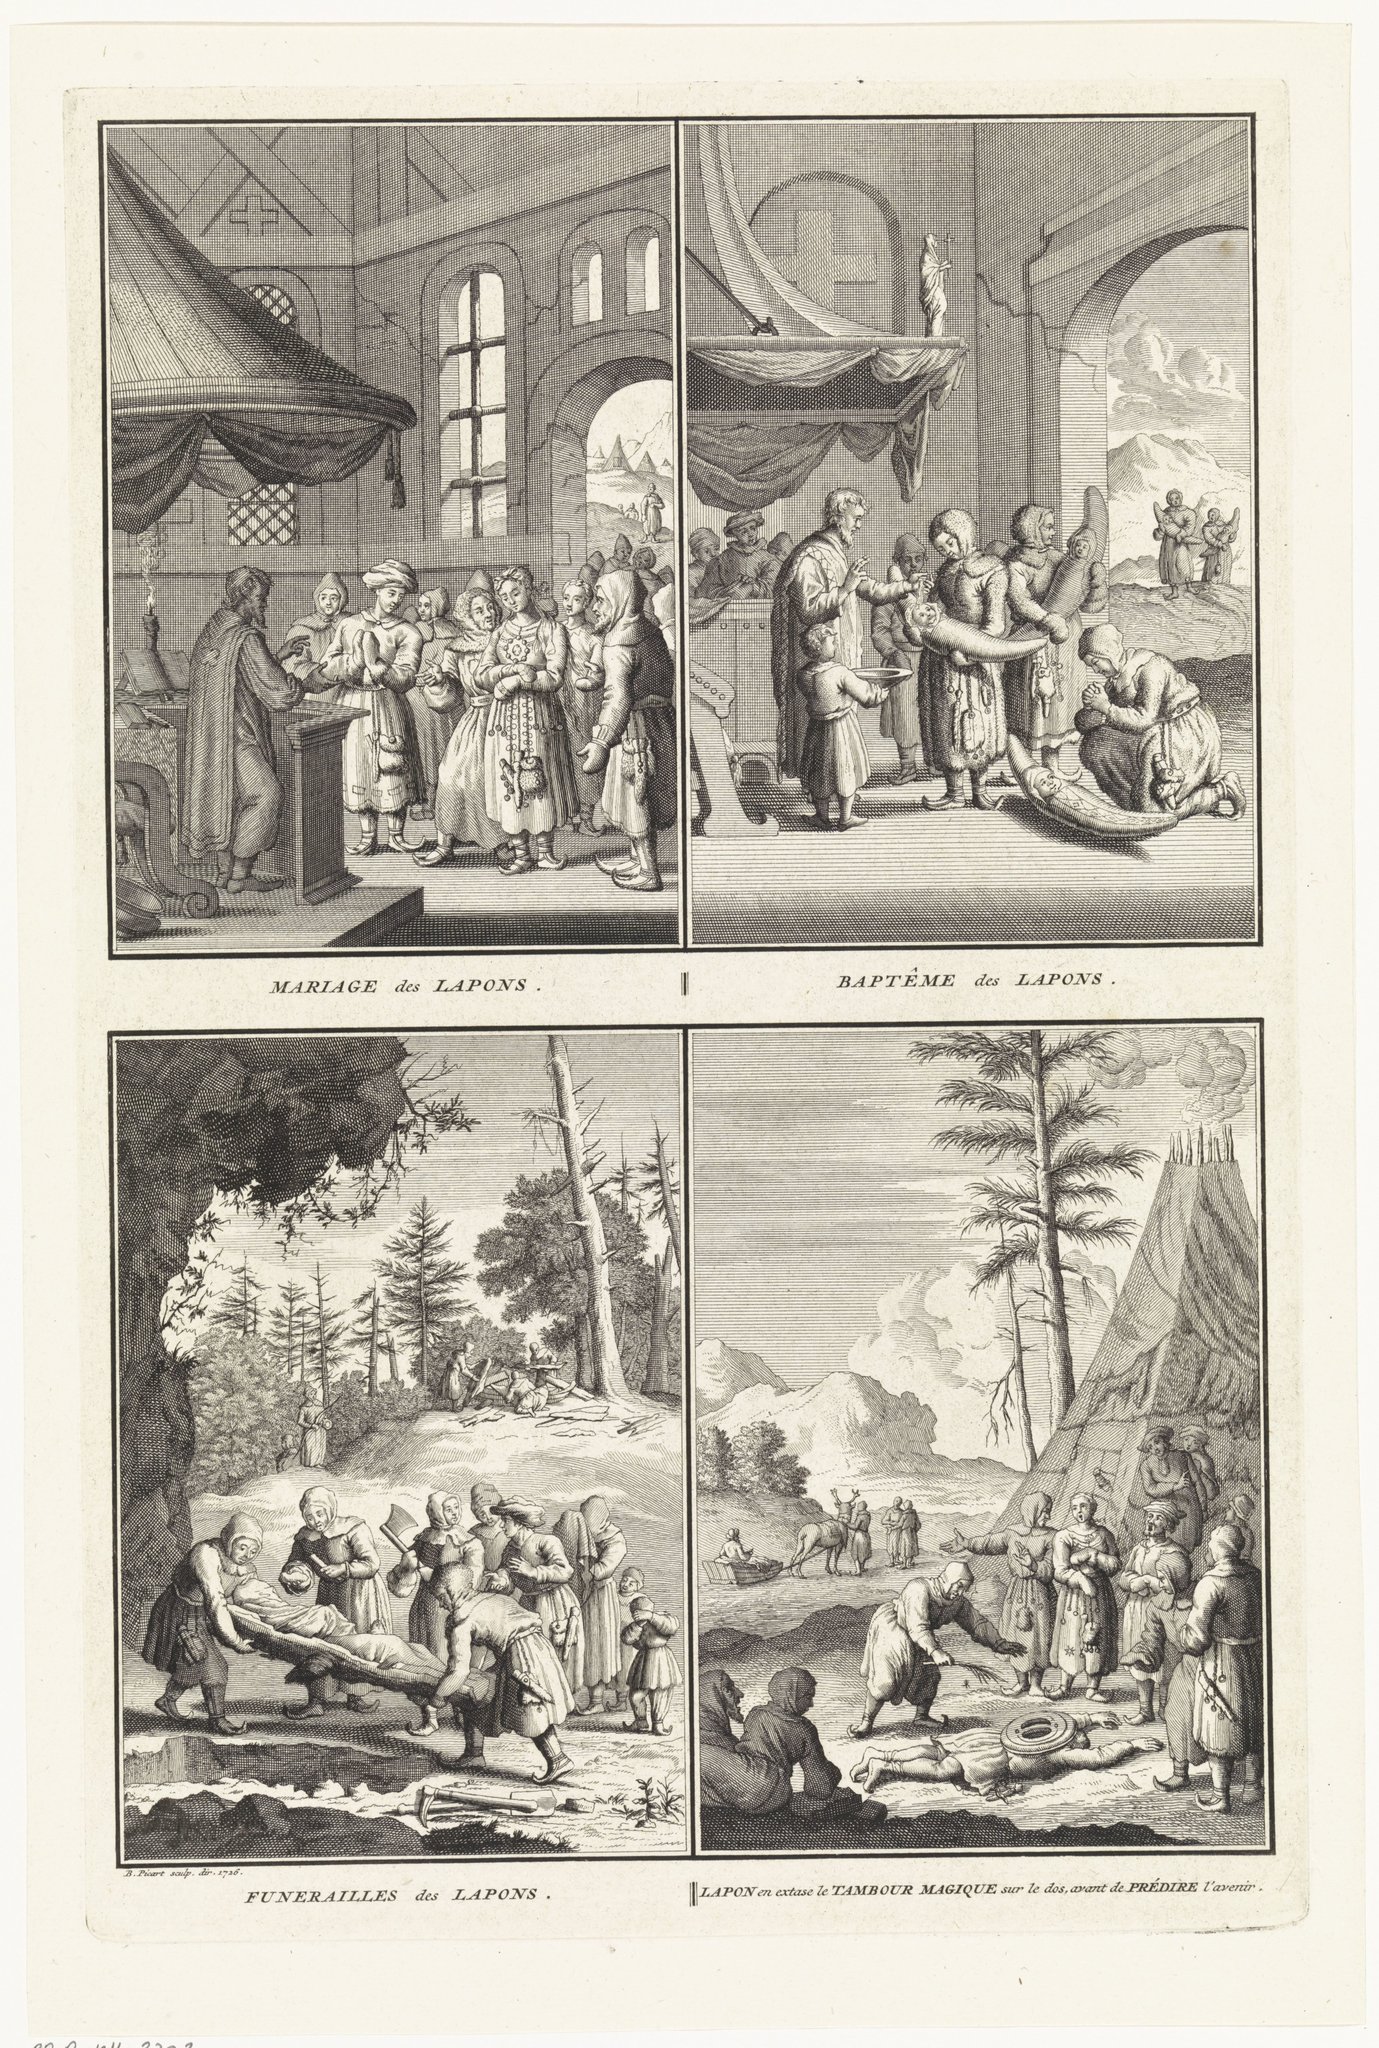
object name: book illustration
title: Verschillende gebruiken van de Sami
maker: bernard picart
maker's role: draughtsman, print maker, publisher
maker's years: 1673-1733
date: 1726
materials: paper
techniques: engraving, etching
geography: amsterdam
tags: ritual practices ~ germanic and scandinavian religions, ritual practices ~ stadia of human life (non-christian religions), europeans: sami, baptism, christening ceremony ~ the first of the seven sacraments, marriage, married couple, 'matrimonium', sápmi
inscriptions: collector's mark: Lugt 2228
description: Blad met vier voorstellingen van Sami gebruiken in Sápmi (Lapland). Linksboven: Een huwelijksvoltrekking in een kerk in Sápmi. Rechtsboven: Doop van een baby in een kerk in Sápmi. Linksonder: Begrafenis in Sápmi. Rechtsonder: Een Same ligt in extase op de grond met een rituele noaidi trommel op zijn rug. Op de achtergrond een rendier voor een slee.